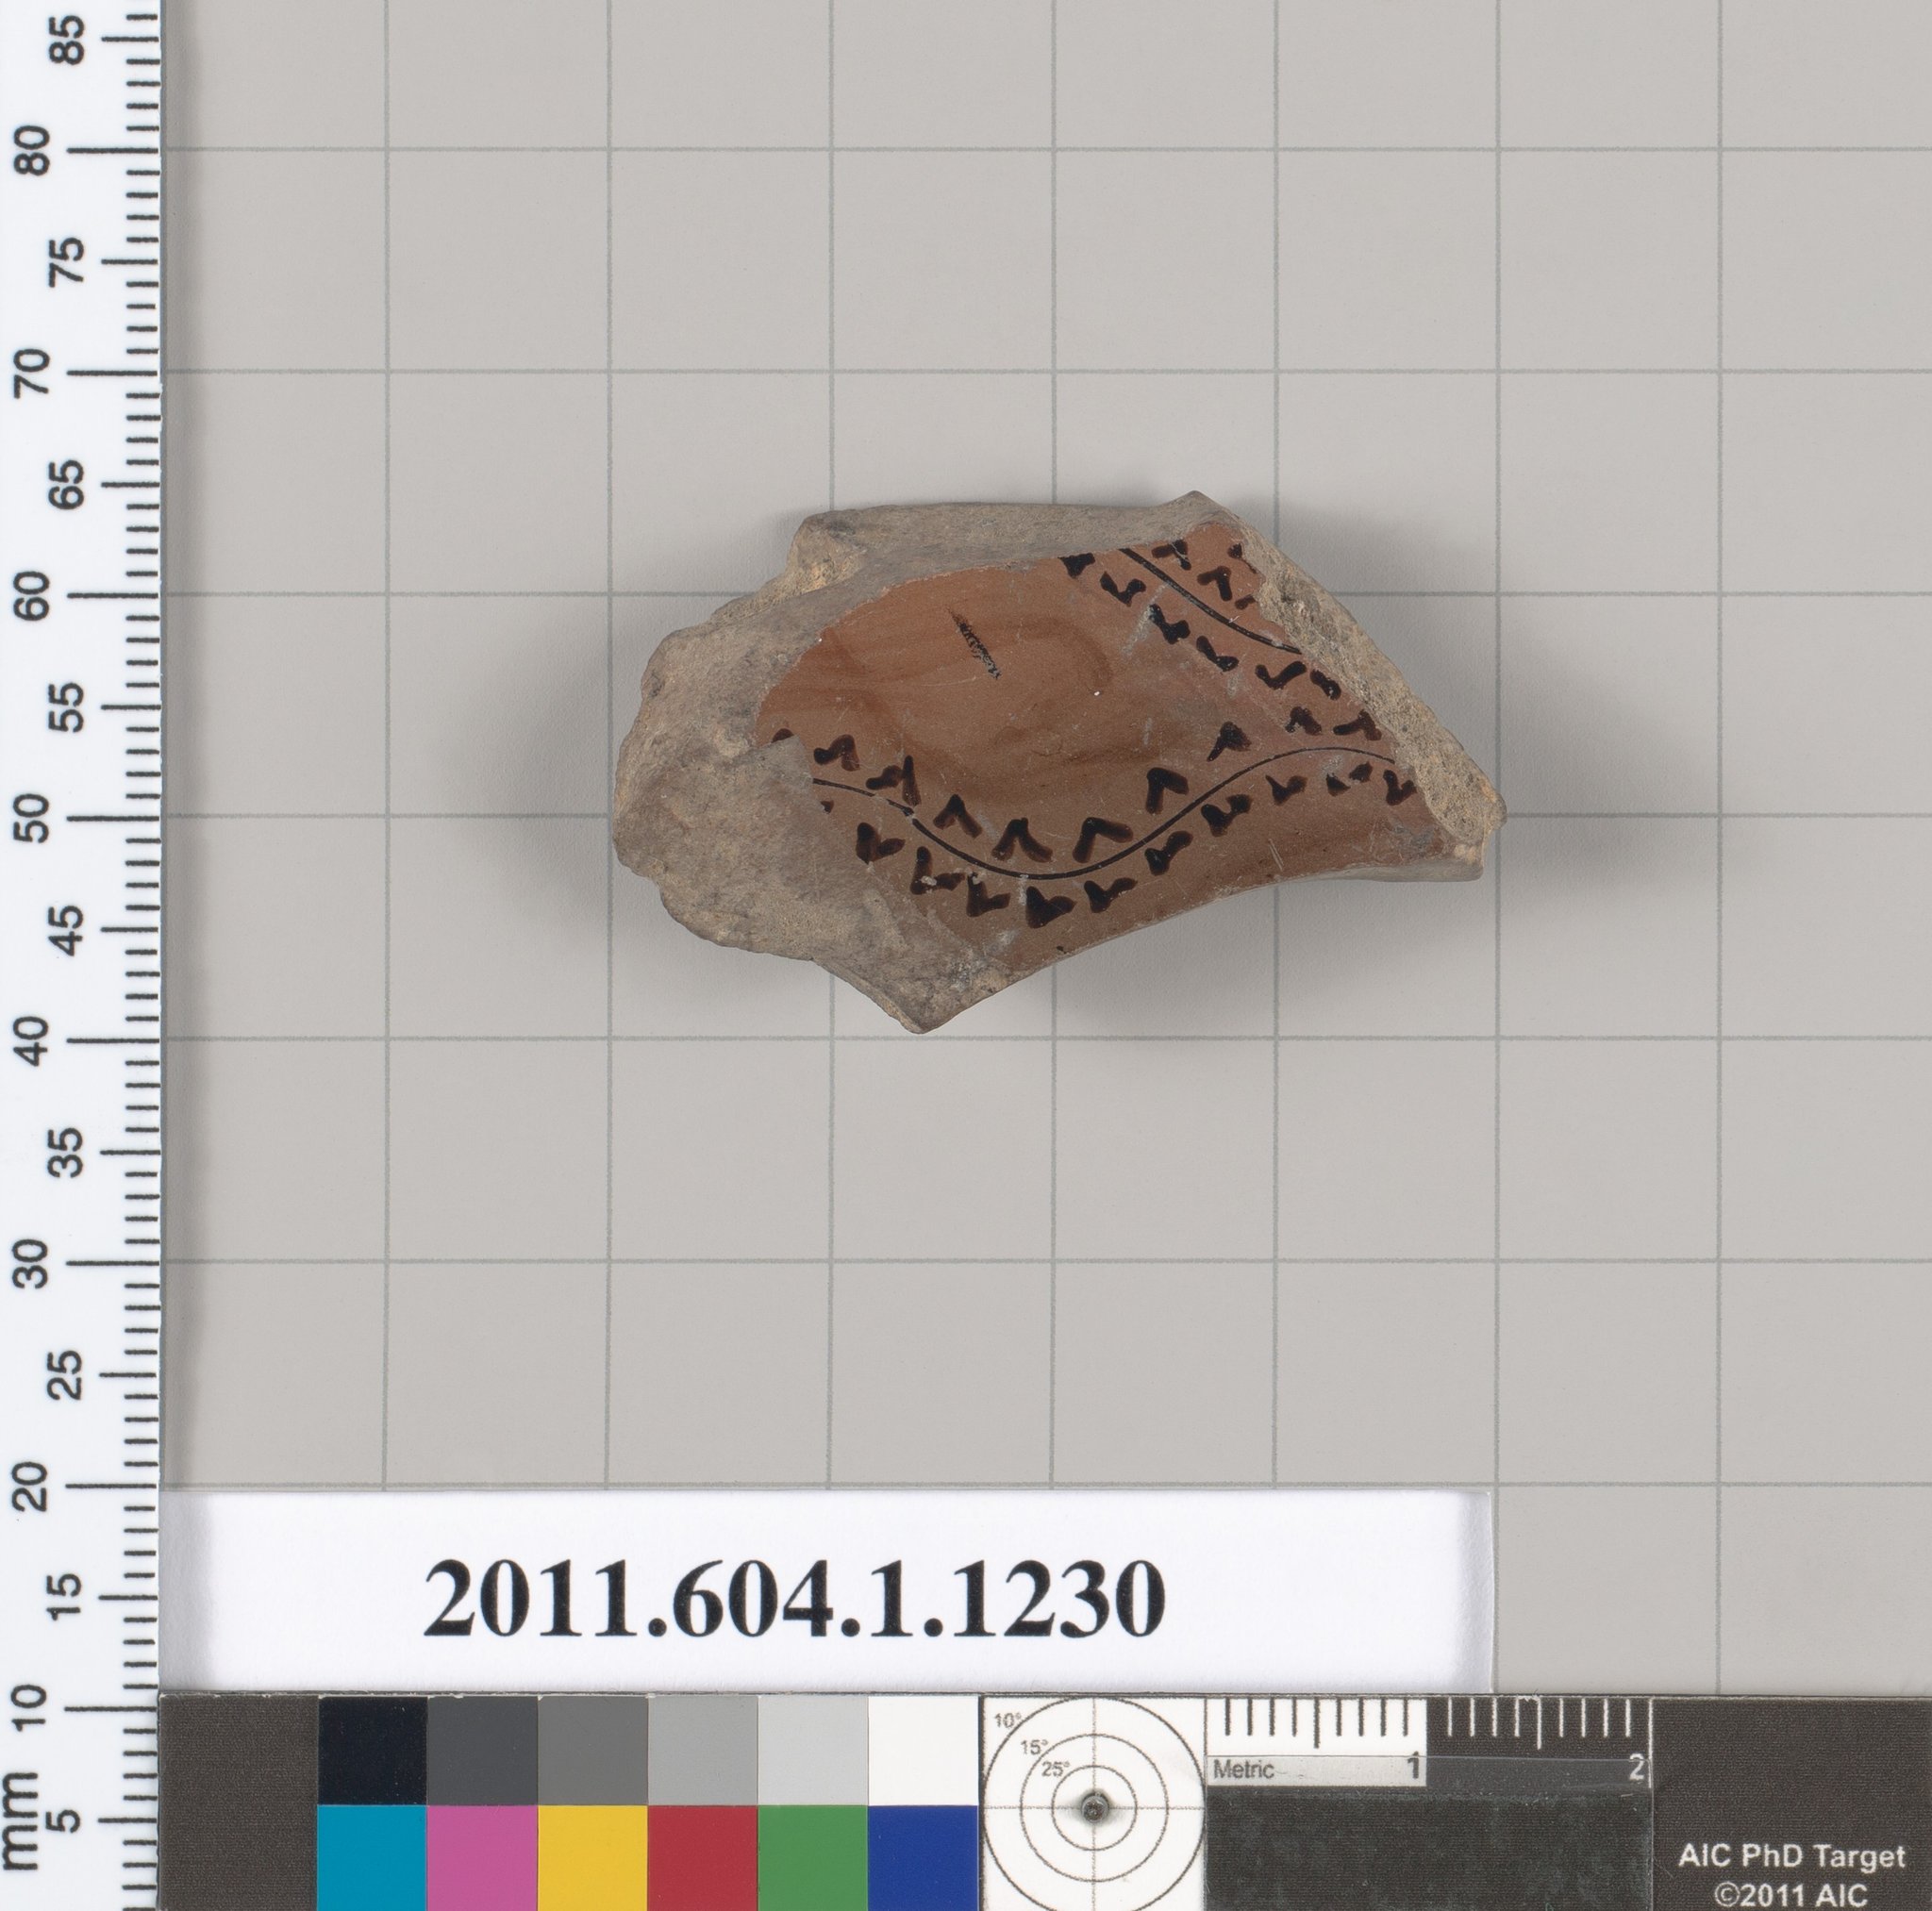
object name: kylix fragment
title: Terracotta fragment of a kylix (drinking cup)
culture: greek, attic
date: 500-480 BCE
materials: terracotta